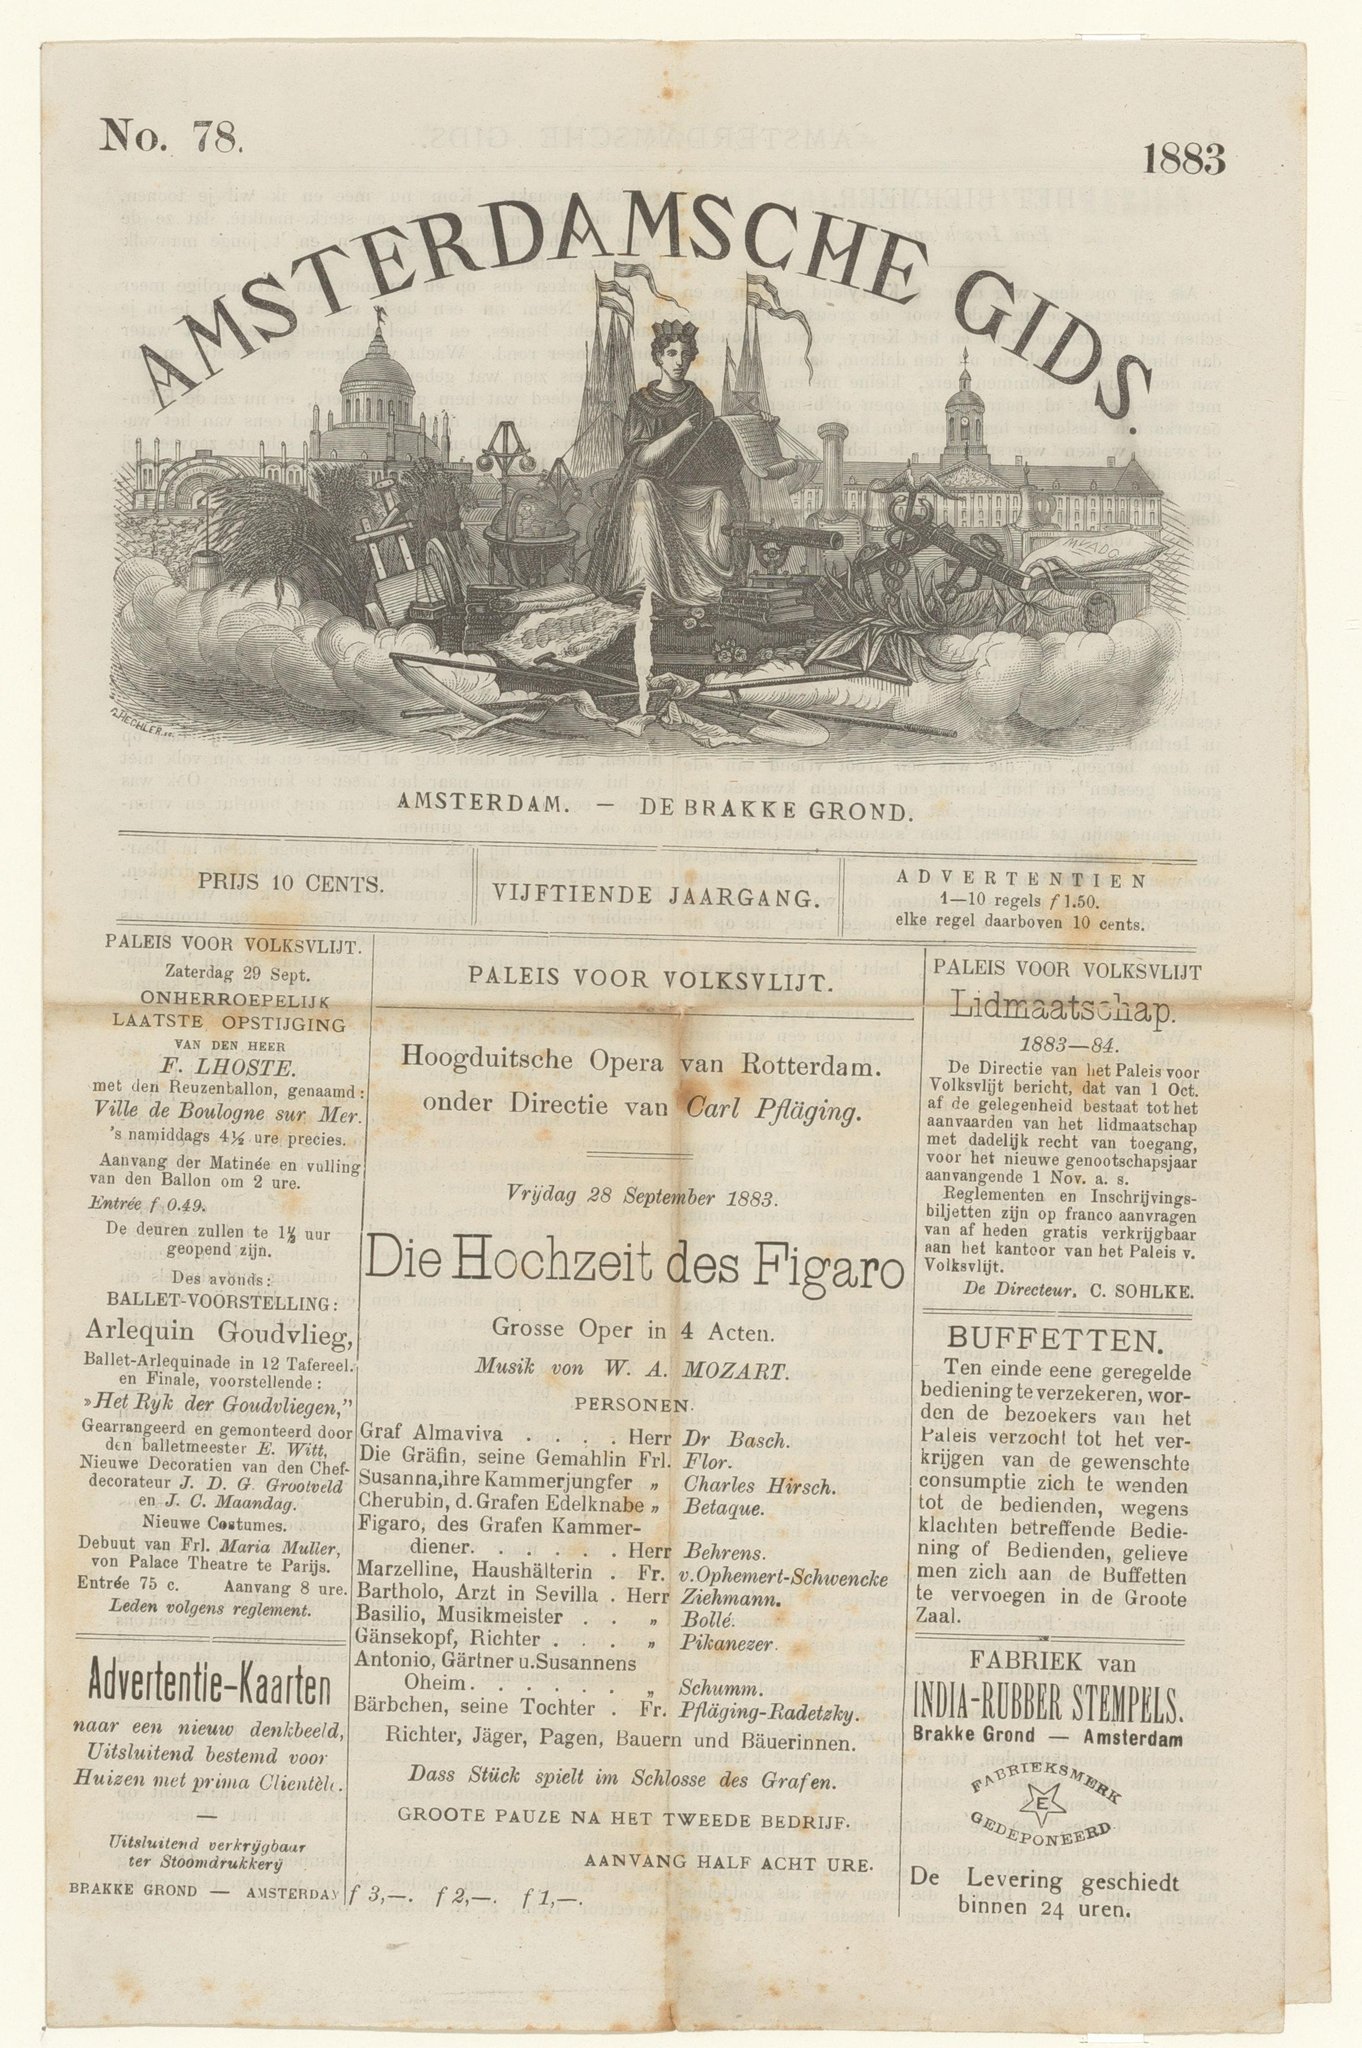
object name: print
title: Amsterdamsche Gids met aankondiging van de voorstelling Die Hochzeit des Figaro, 1883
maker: Anonymous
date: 1883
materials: paper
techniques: letterpress printing, engraving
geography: amsterdam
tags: theatre, theatrical performance, advertisement, notice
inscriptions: stamp, collector's mark: Lugt 1641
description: Een gevouwen blad vormt vier pagina's. Op de eerste pagina een aankondiging van de aankomende voorstelling Die Hochzeit des Figaro in de Stadsschouwburg in 1883. Op de overige pagina's advertenties. Linksboven genummerd: No. 78. Onderwerpsrubrieken binnen de Atlas Zeden en Gewoonten: Tooneel, Toneelprogramma’s.